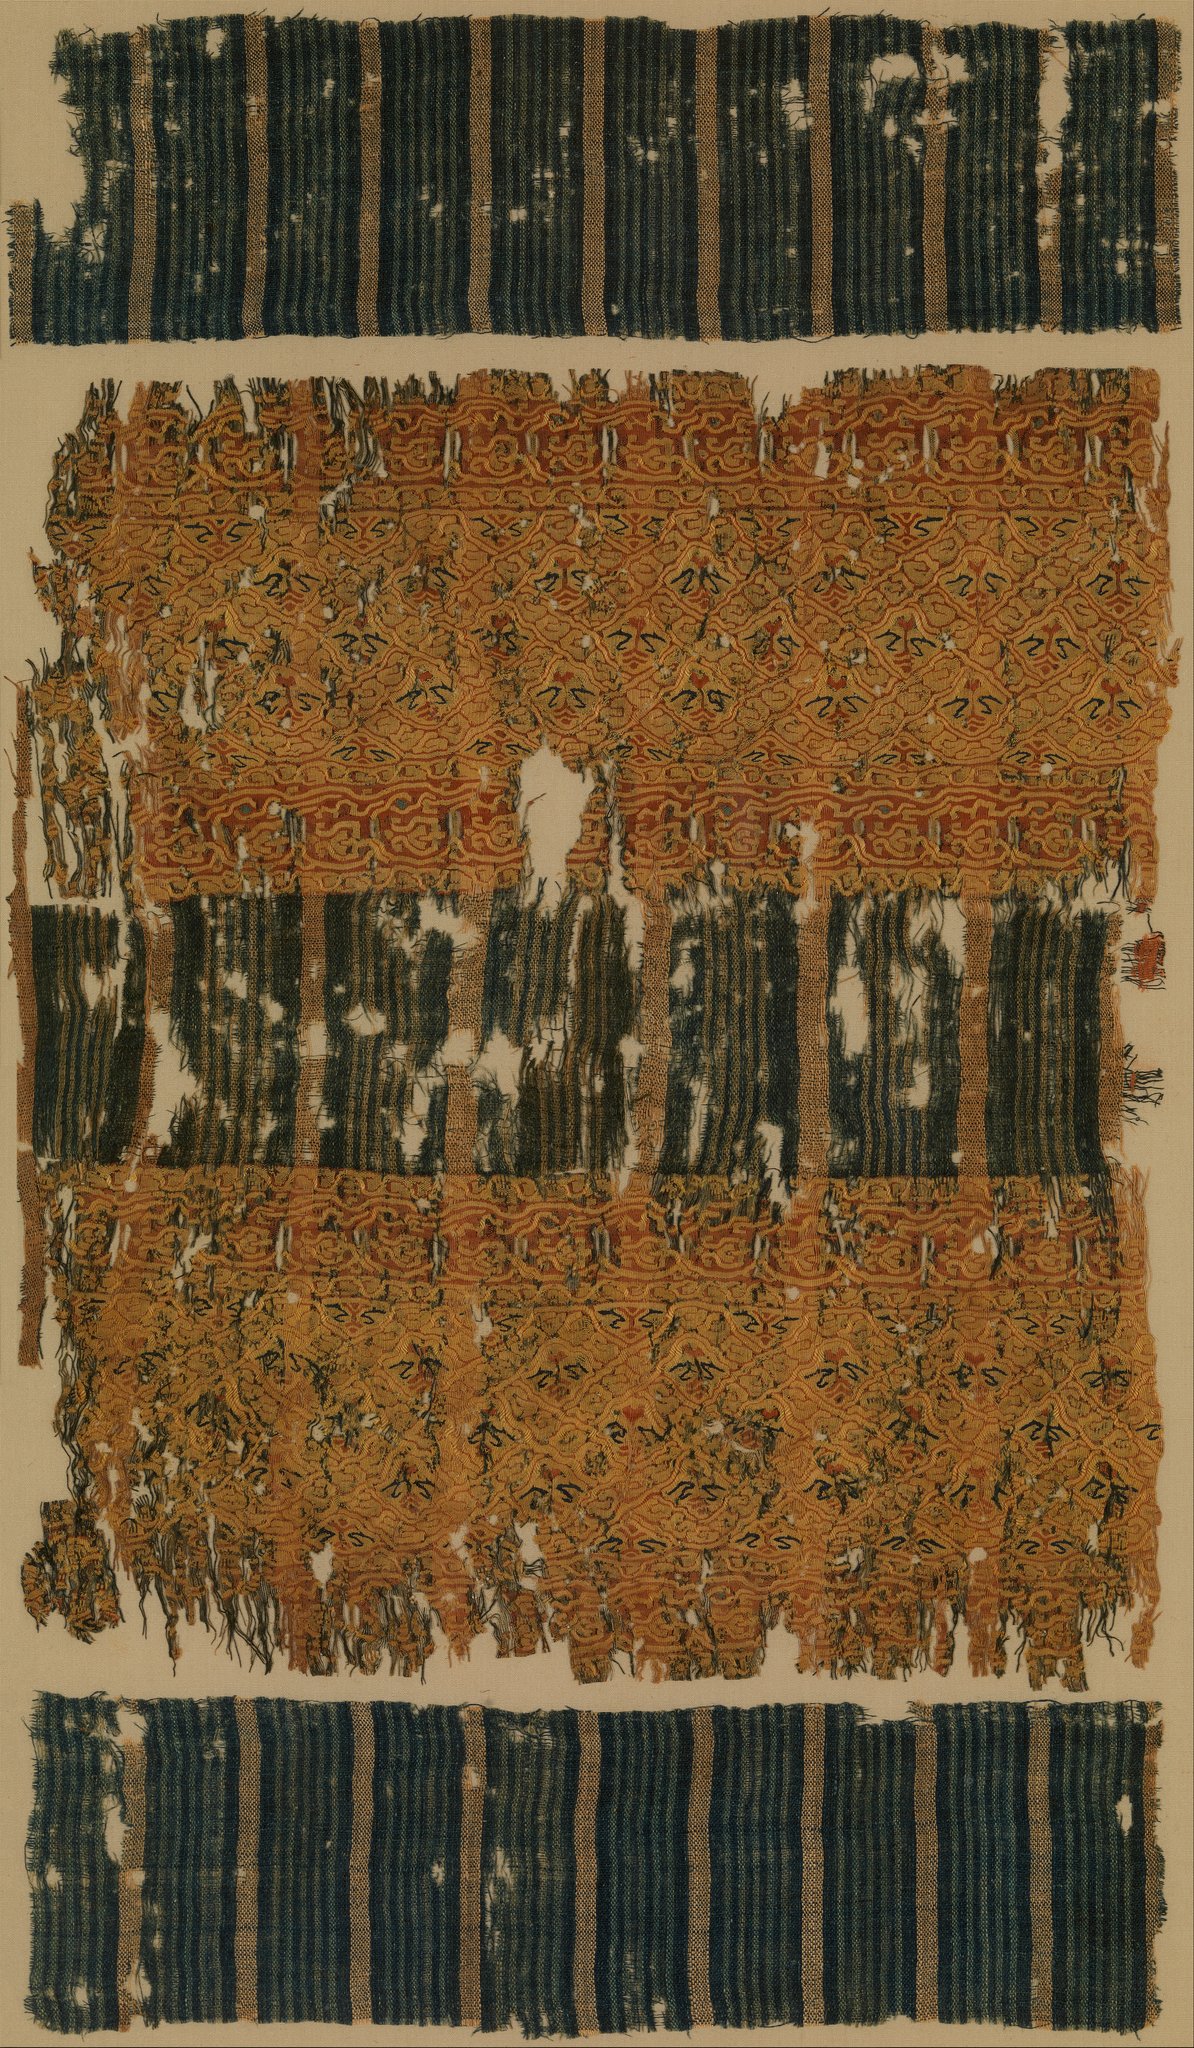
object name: textile fragment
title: Textile with Stripes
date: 1101-1200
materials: linen, silk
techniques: weave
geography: egypt